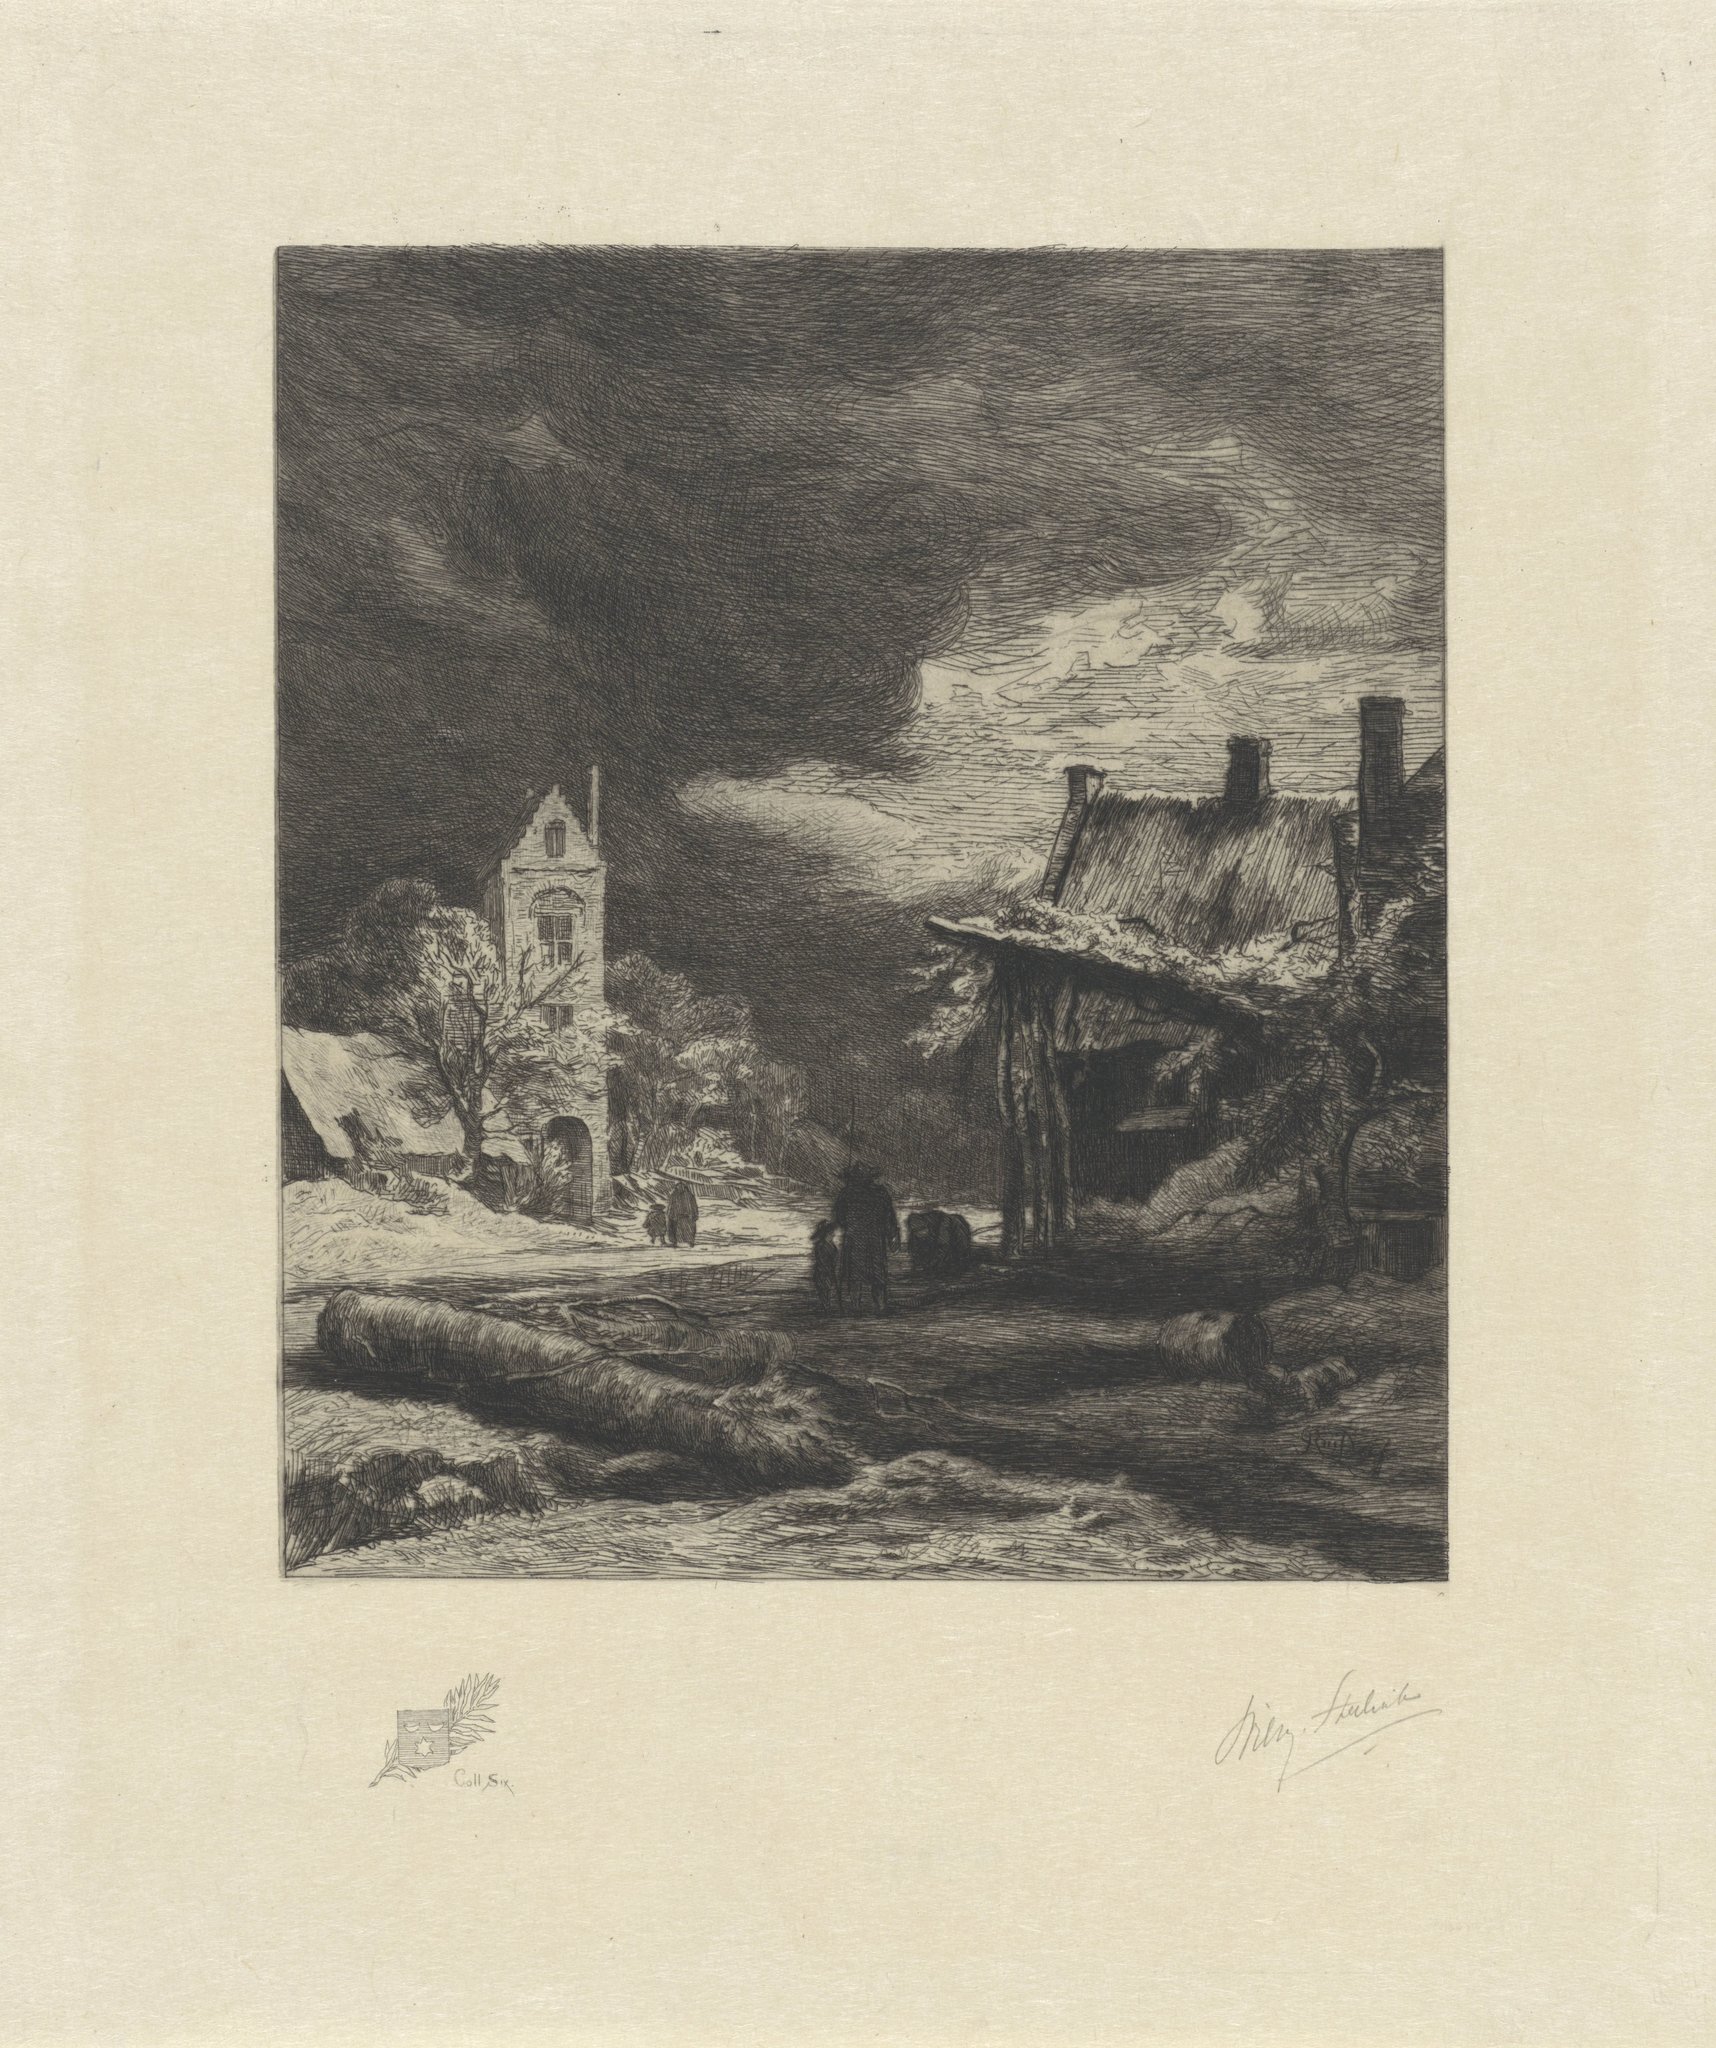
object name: print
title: Winterlandschap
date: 1888-1891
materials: paper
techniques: etching, intaglio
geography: netherlands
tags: landscapes in the temperate zone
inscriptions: collector's mark: Lugt 2228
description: Prent mogelijk gebruikt in: Oude kunst in Nederland : etsen van Wilm. Steelink, naar schilderijen uit de kabinetten van A. Bredius, A.J. Enschedé, J.P. Six, P.H. Siz, H.A. Steengracht van Duivenvoorde, Victor de Stuers en andere verzamelingen. Amsterdam: Van Holkema & Warendorf, 1888-1891.